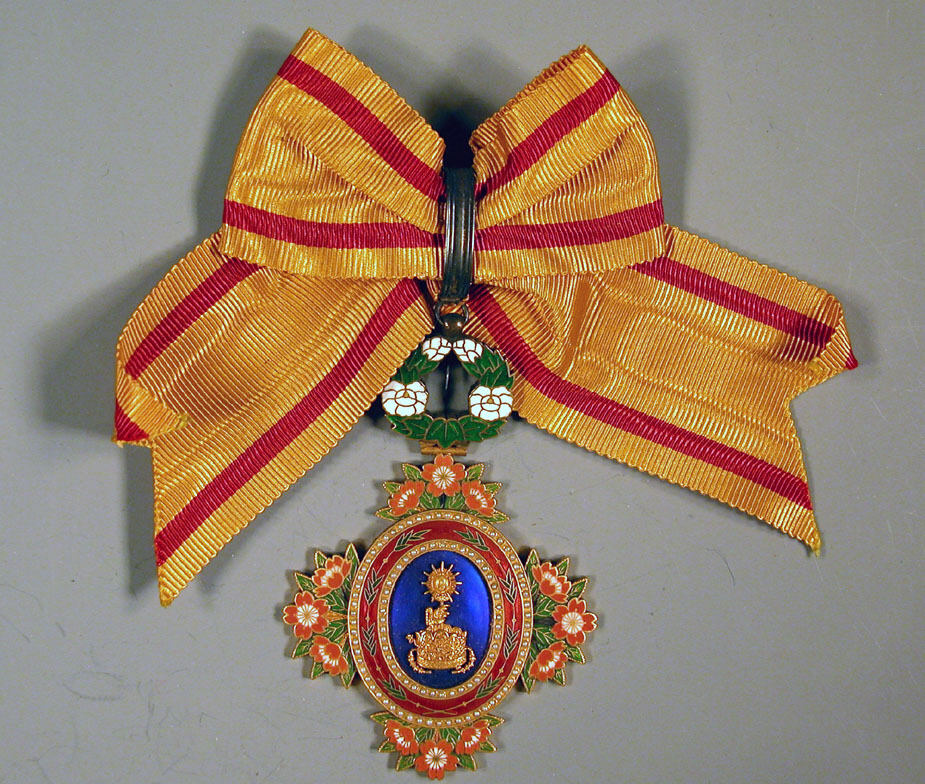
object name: medal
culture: japanese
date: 1867-1900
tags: flowers